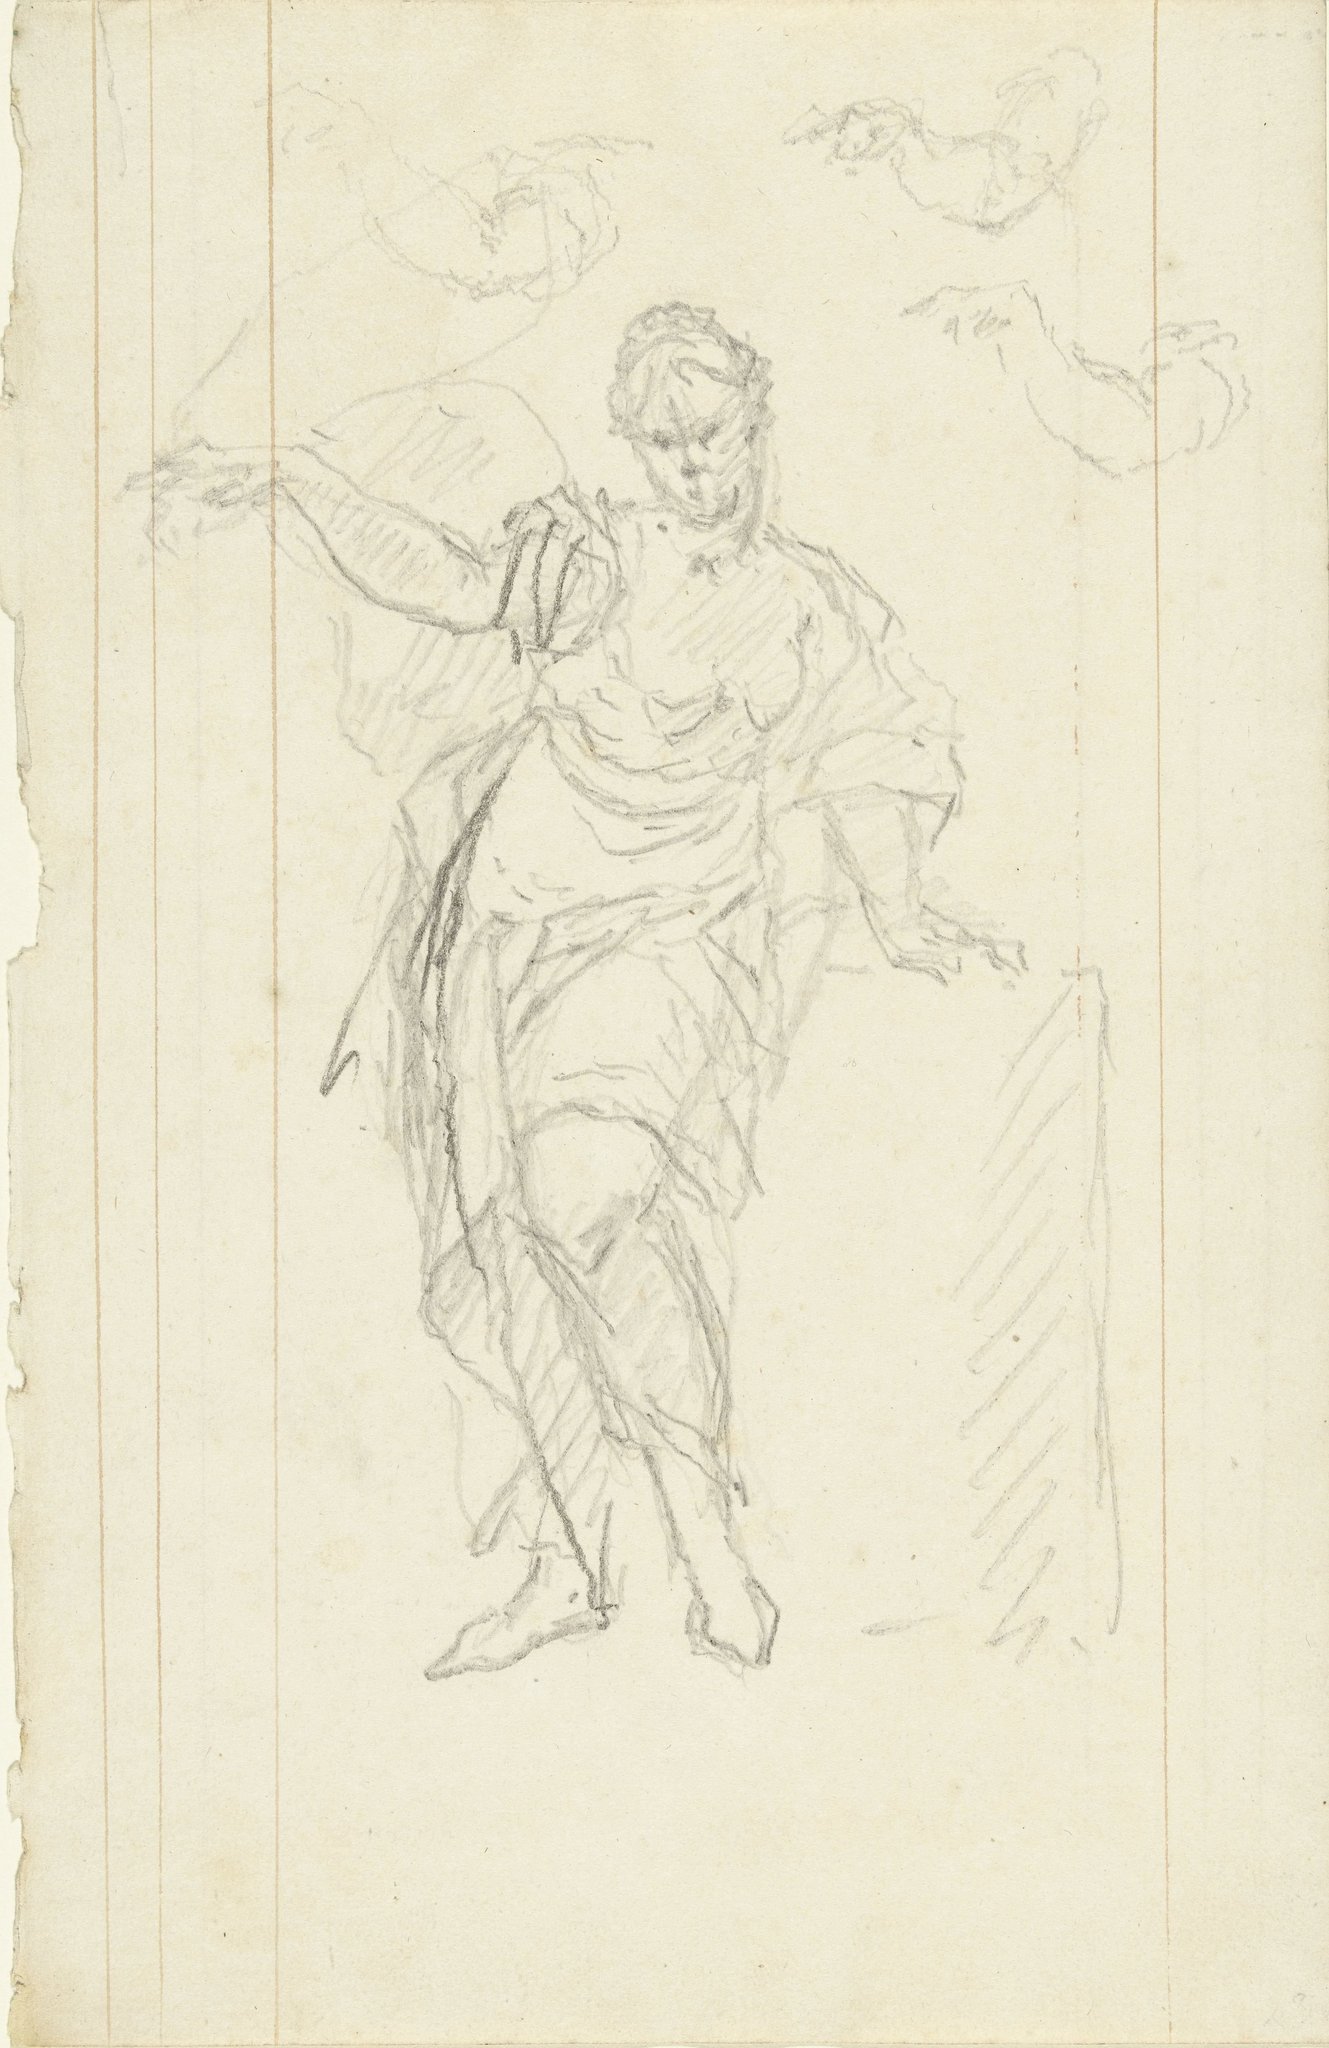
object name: drawing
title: Schetsblad met een staande vrouw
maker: dionys van nijmegen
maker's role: draughtsman, painter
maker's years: 1705-1798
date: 1715-1798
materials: paper, pencil